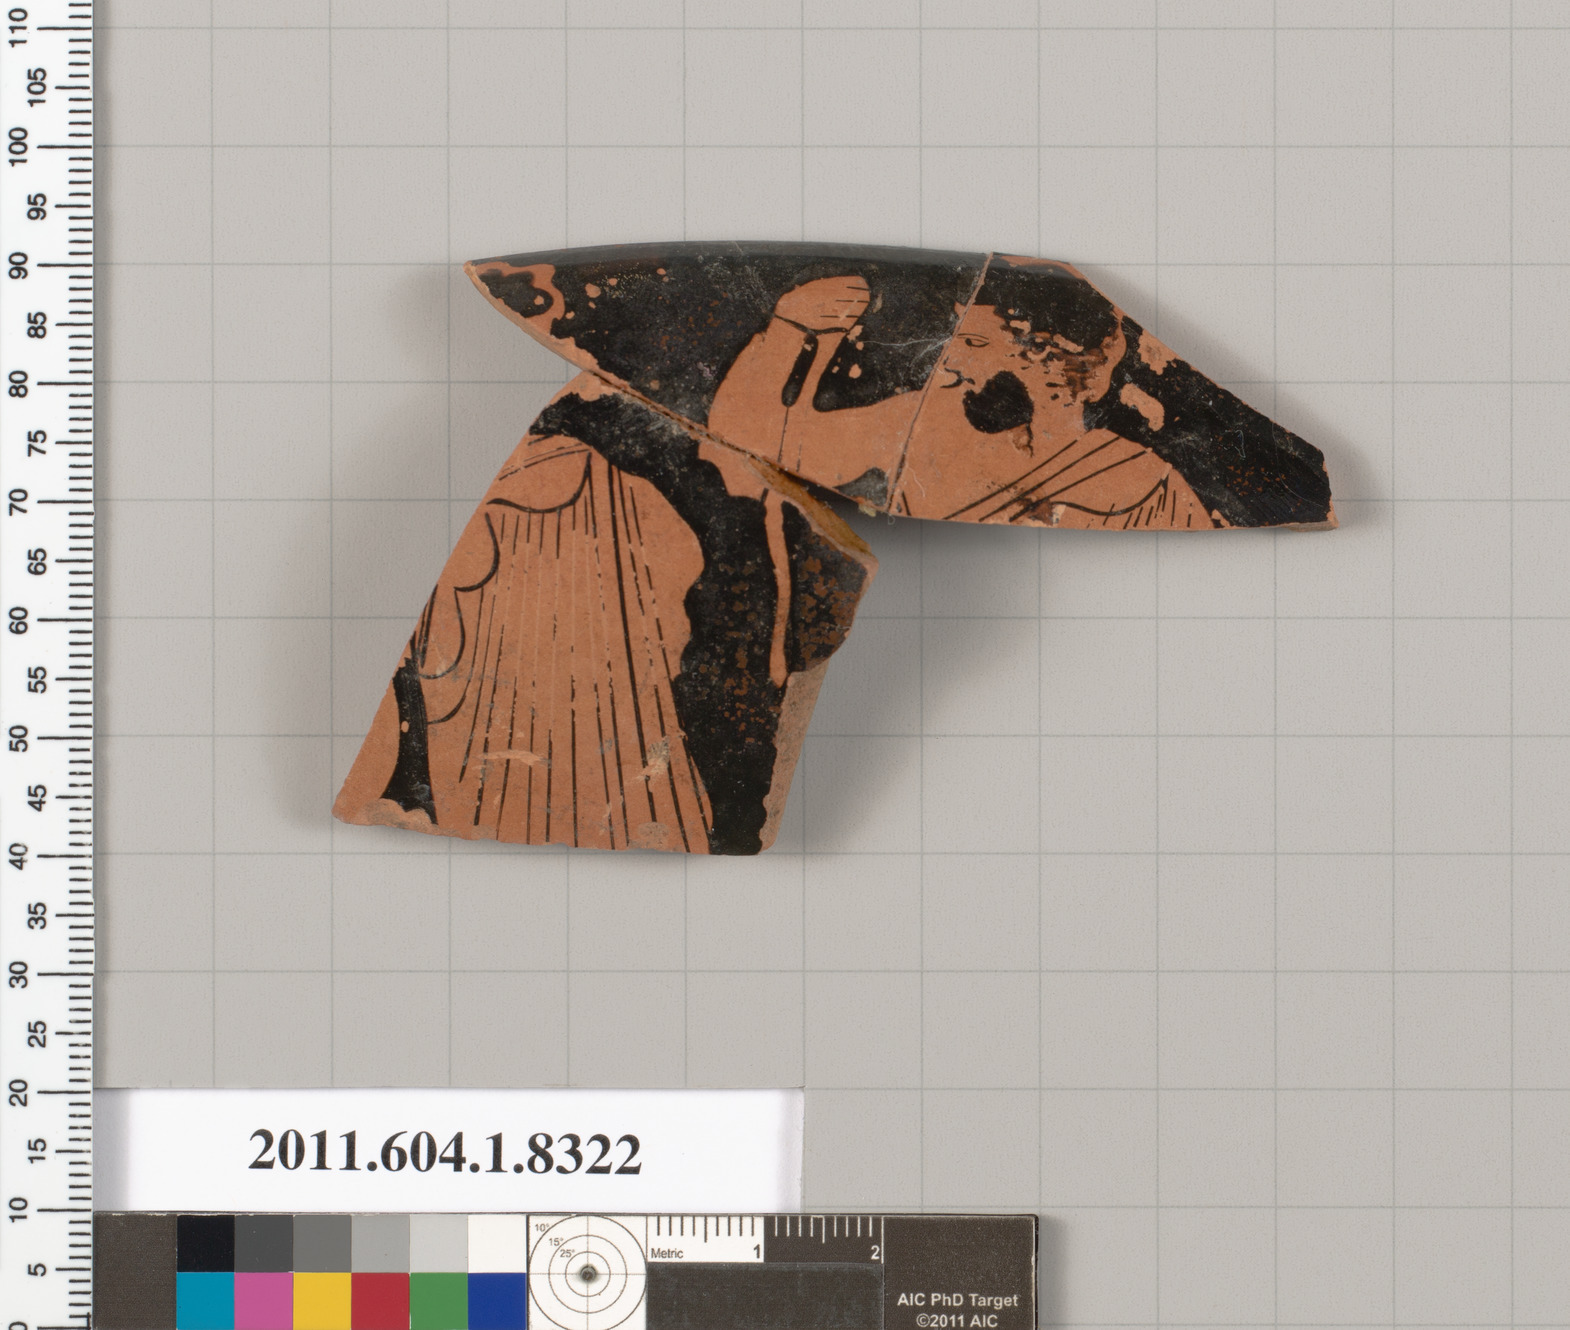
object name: kylix fragment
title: Terracotta rim fragment of a kylix (drinking cup)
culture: greek, attic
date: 425-401 BCE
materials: terracotta